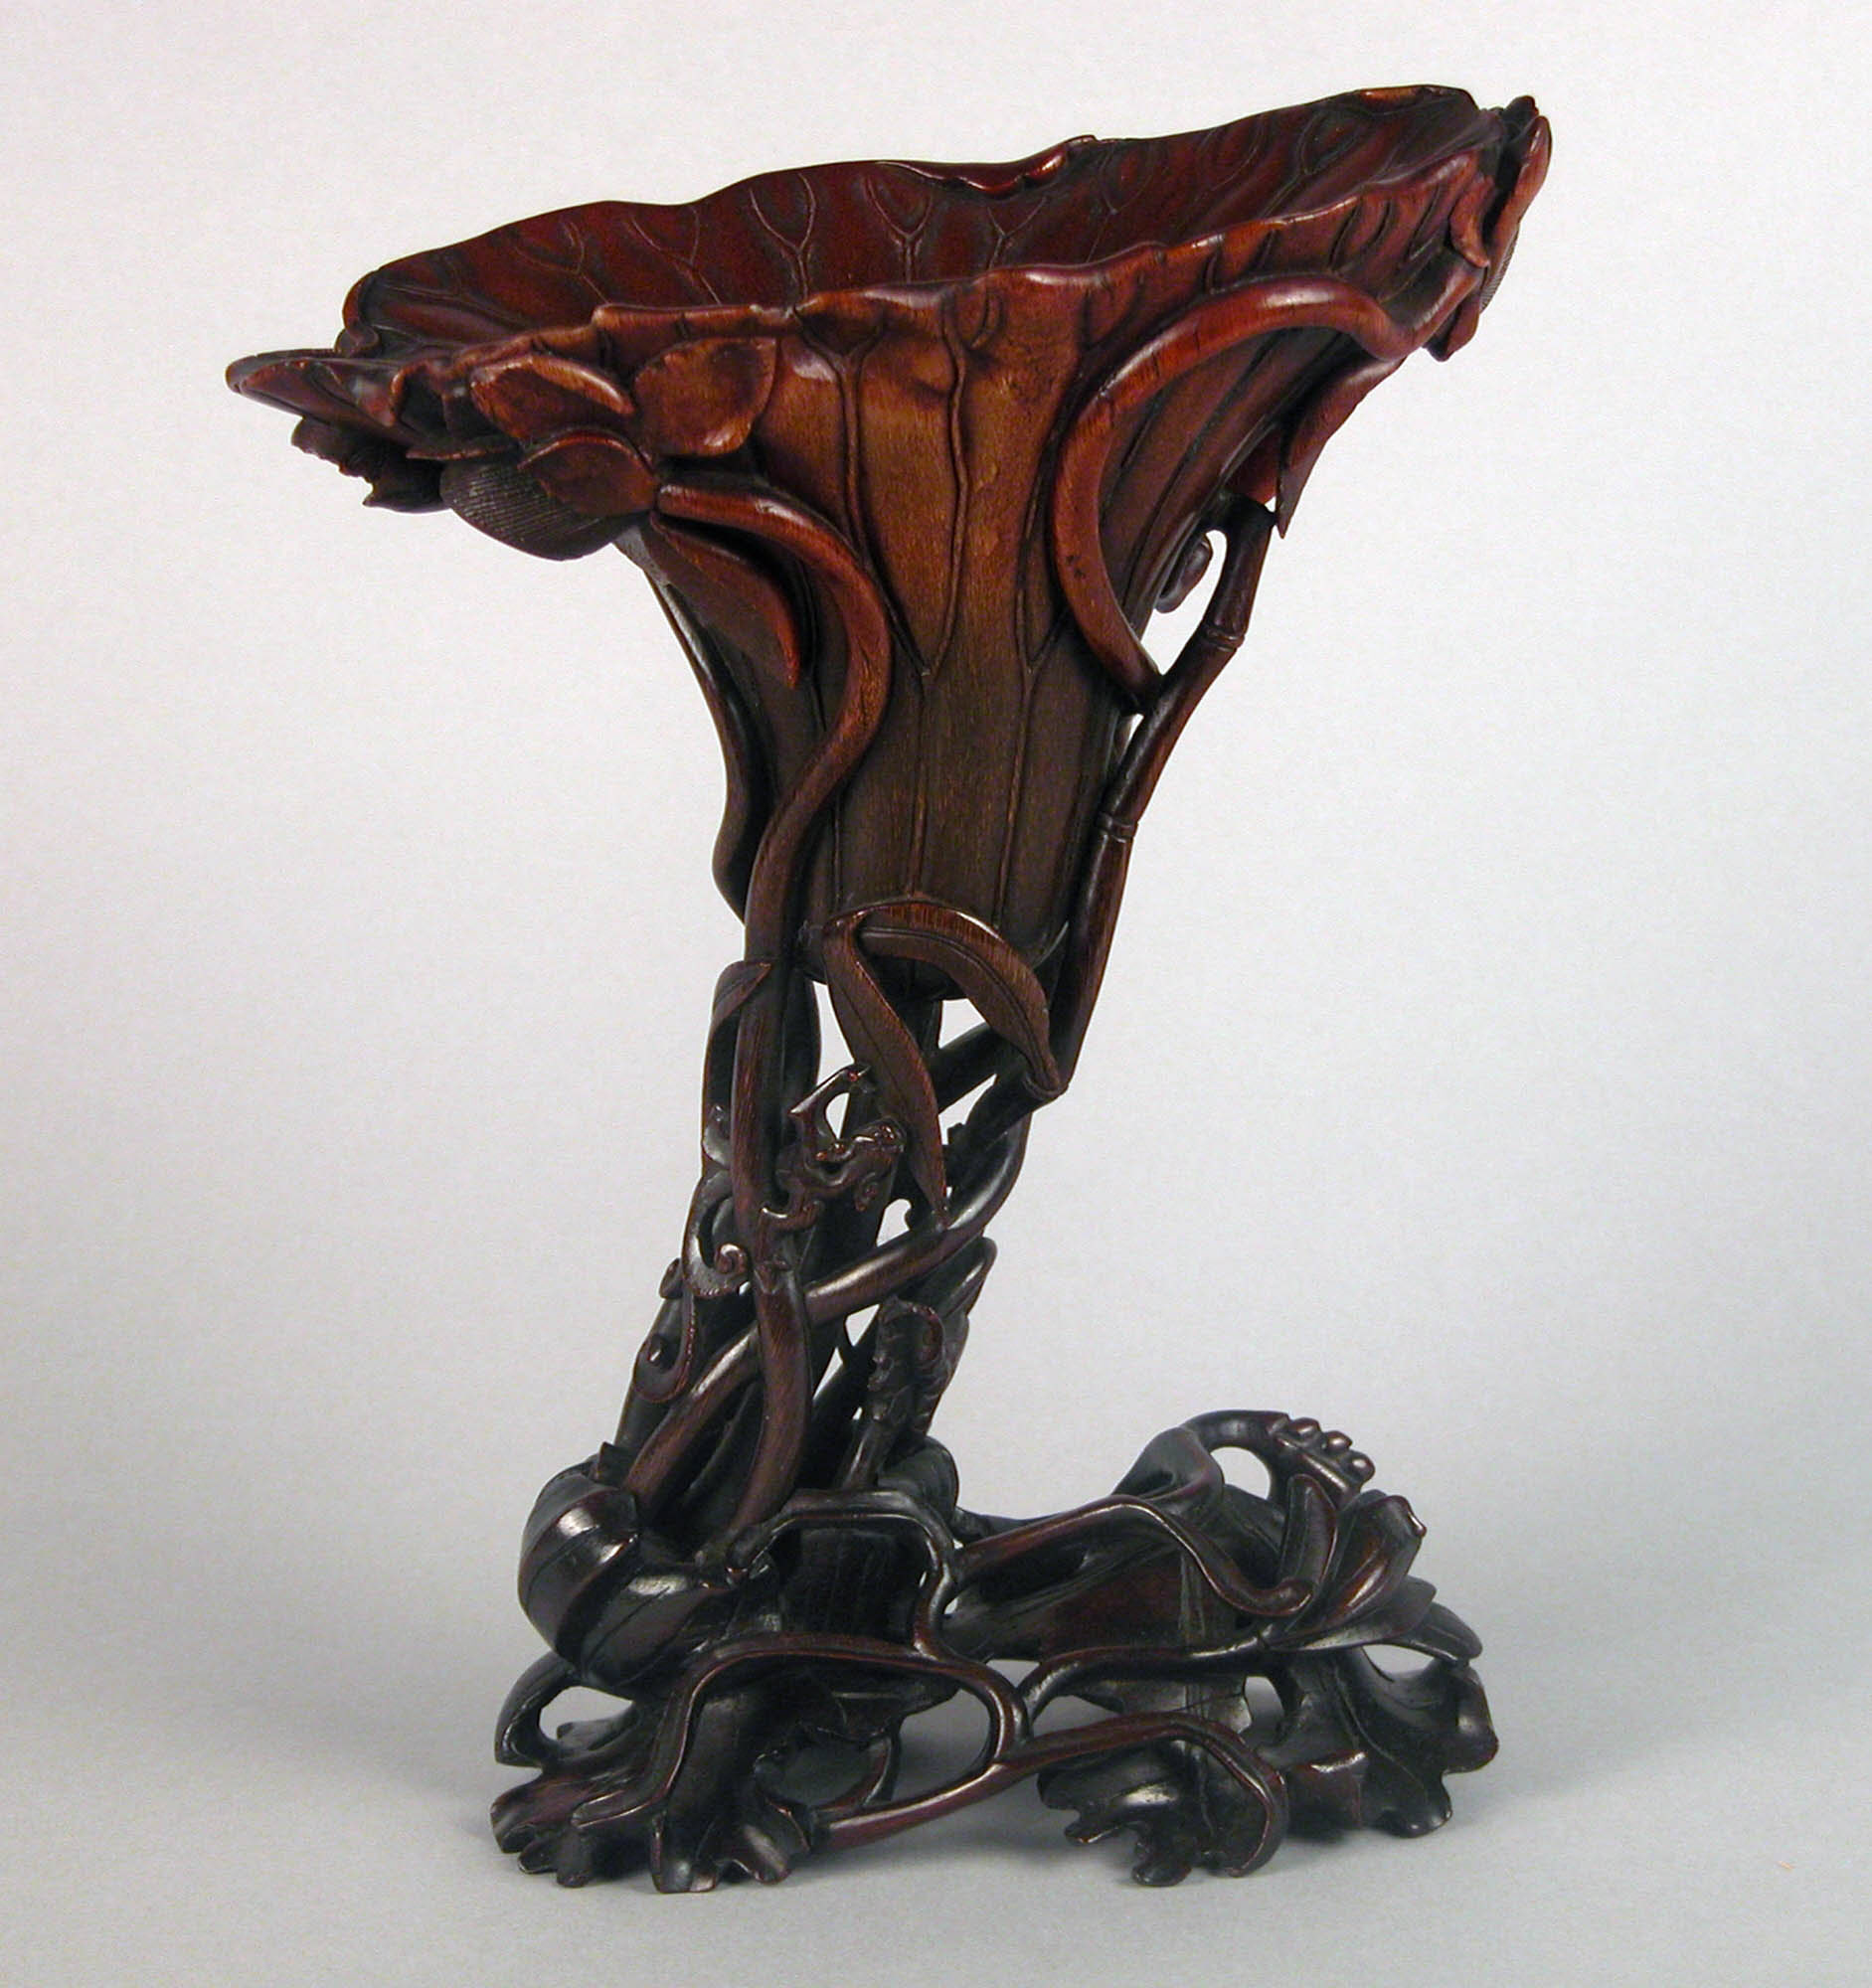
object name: cup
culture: chinese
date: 1701-1800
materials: horn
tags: plants